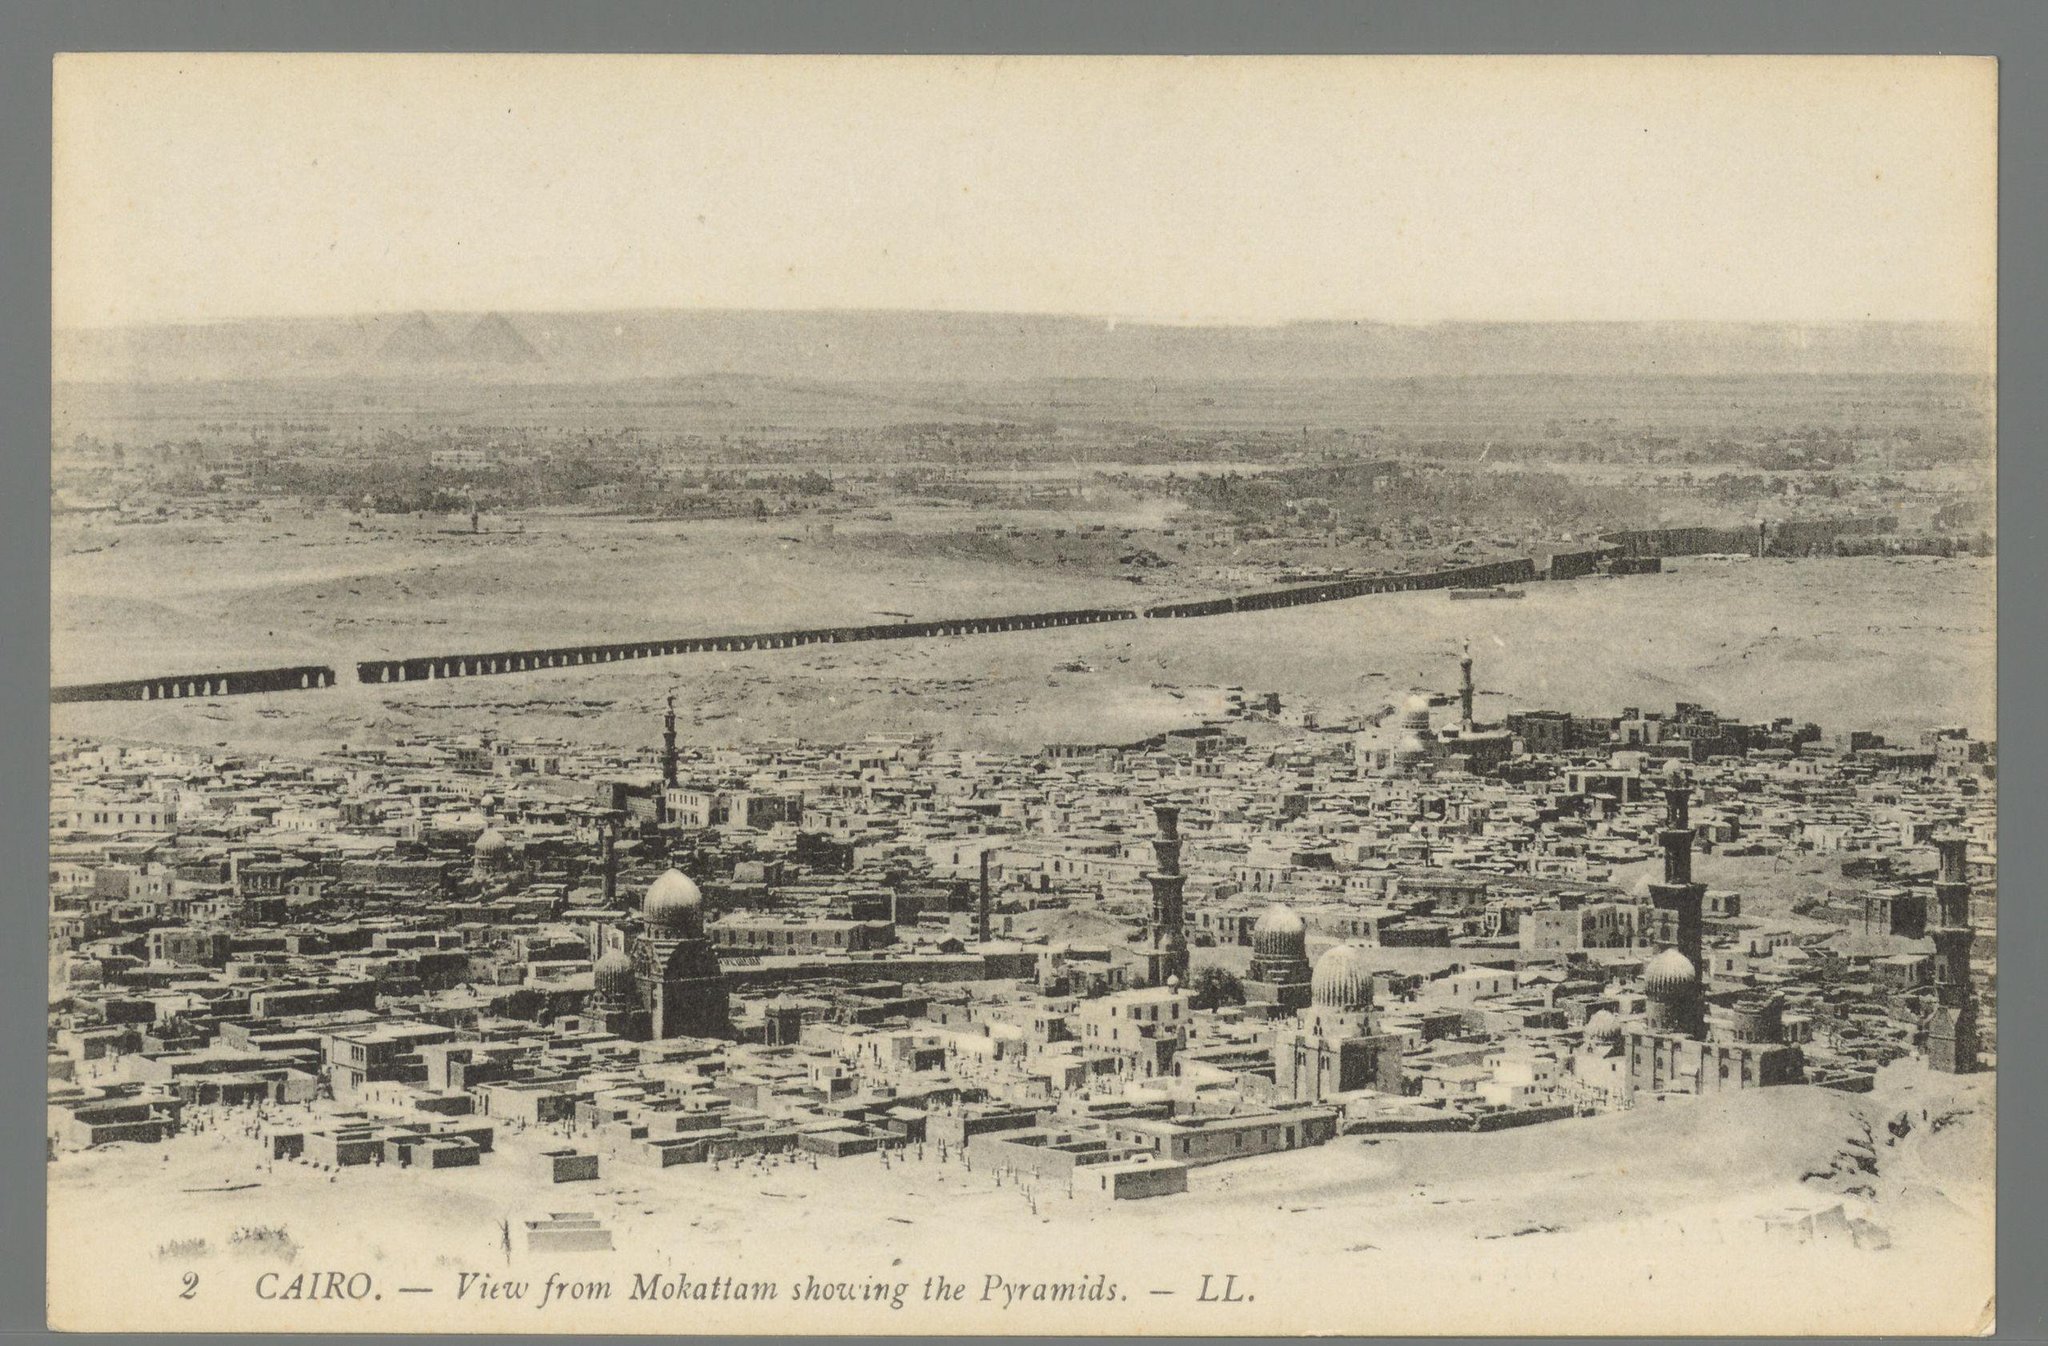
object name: ansichtkaart, prentbriefkaart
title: Cairo - View from Mokattam showing the Pyramids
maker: Anonymous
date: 1907-1930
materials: cardboard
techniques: photograph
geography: cairo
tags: city-view, and landscape with man-made constructions, quadrangular pyramid